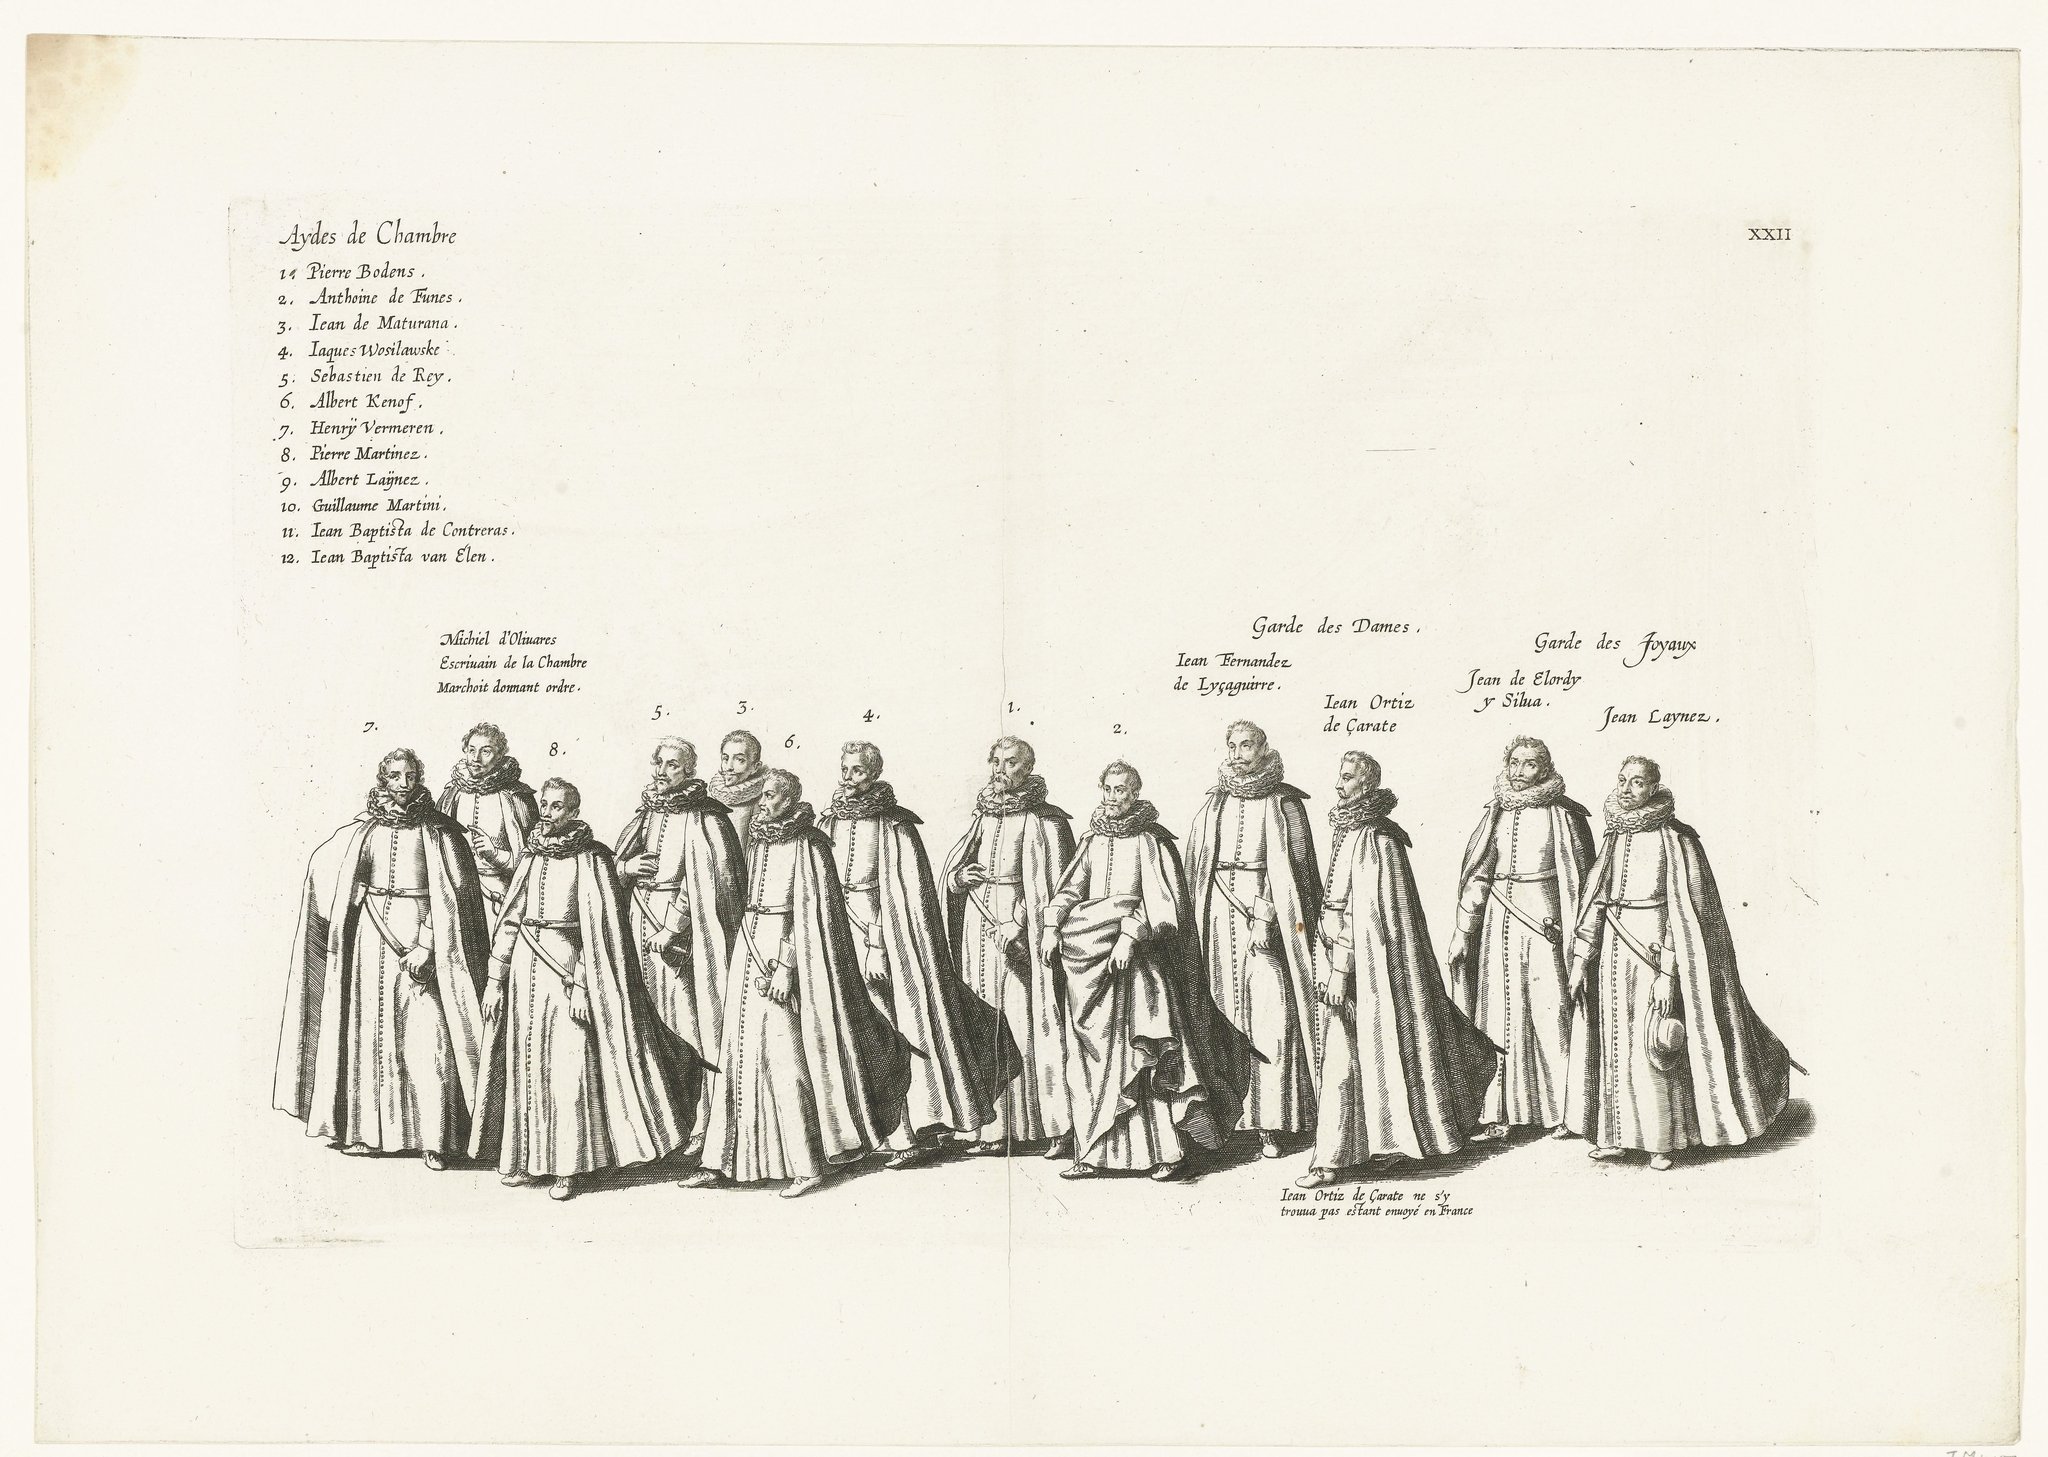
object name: print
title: Begrafenisstoet van aartshertog Albrecht (plaat XXII), 1622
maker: cornelis galle (i)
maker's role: print maker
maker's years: 1576-1650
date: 1623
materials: paper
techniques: etching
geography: southern netherlands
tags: brussels, albrecht aartshertog van oostenrijk, cortege, funeral procession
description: Deelnemers aan de begrafenisstoet. Plaat XXII in de serie van de begrafenis van aartshertog Albrecht van Oostenrijk te Brussel op 12 maart 1622.